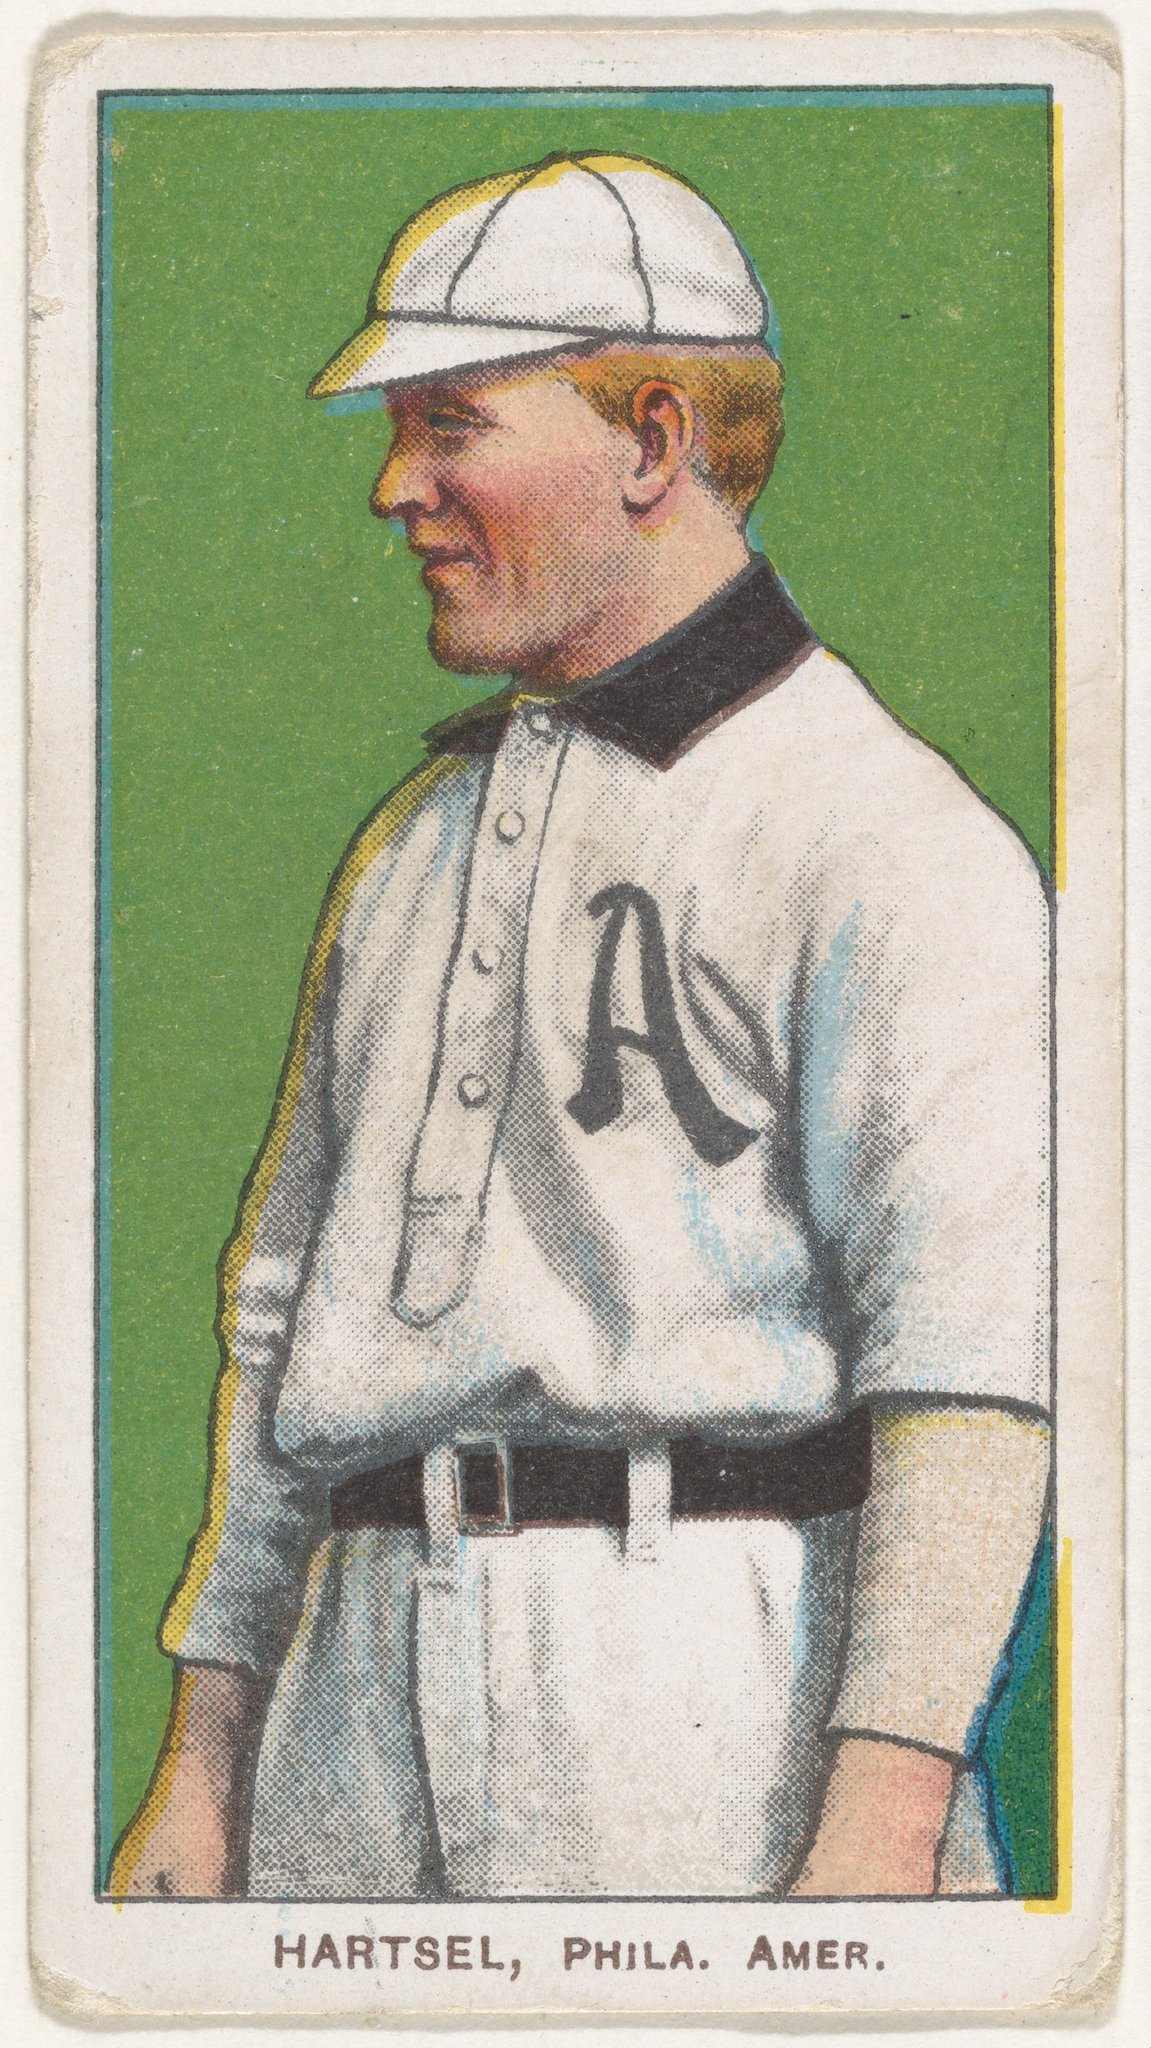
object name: baseball card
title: Hartsel, Philadelphia, American League, from the White Border series (T206) for the American Tobacco Company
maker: american tobacco company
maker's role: publisher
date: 1909-1911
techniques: color lithograph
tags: men,baseball,athletes